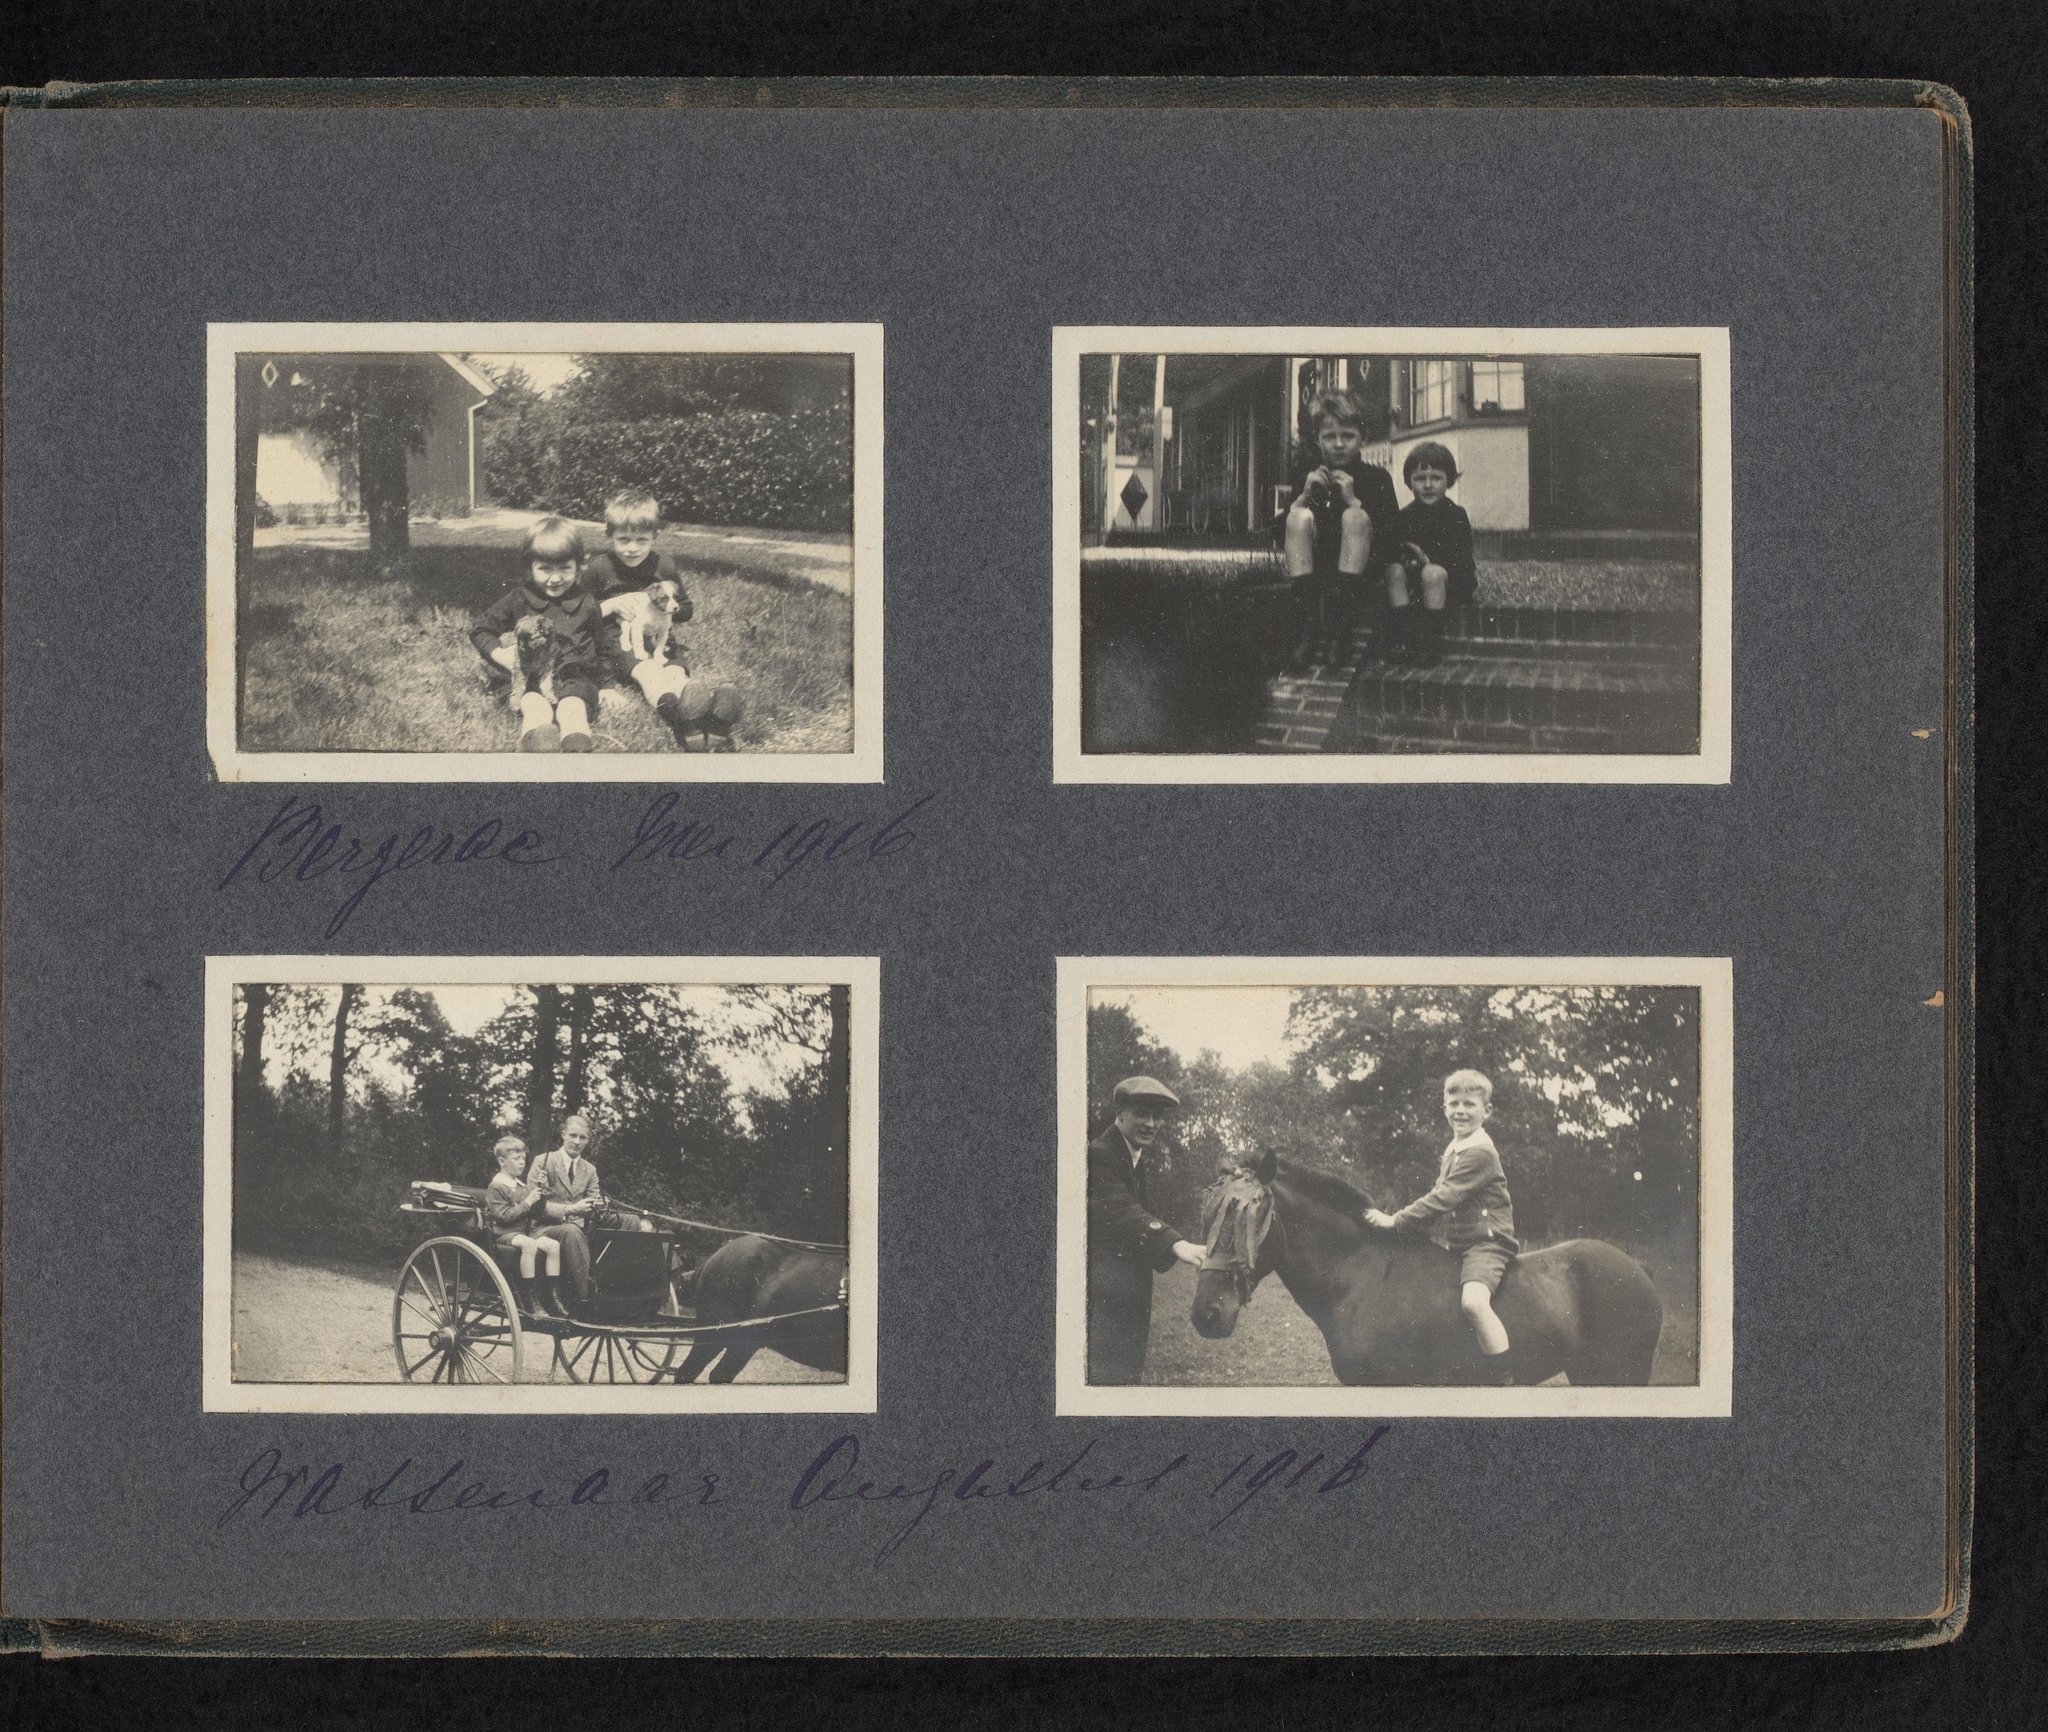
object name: photograph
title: Carel en Frank van den Berg in Bergerac en Wassenaar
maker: hendrik herman van den berg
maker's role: amateurfotograaf, jurist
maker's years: 1875-1944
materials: paper, cardboard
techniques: gelatin silver print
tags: carel frederik van den berg (cay), amsterdam, frank willem van den berg (1912-1998), child, horse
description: Deze foto's zijn onderdeel van een album.